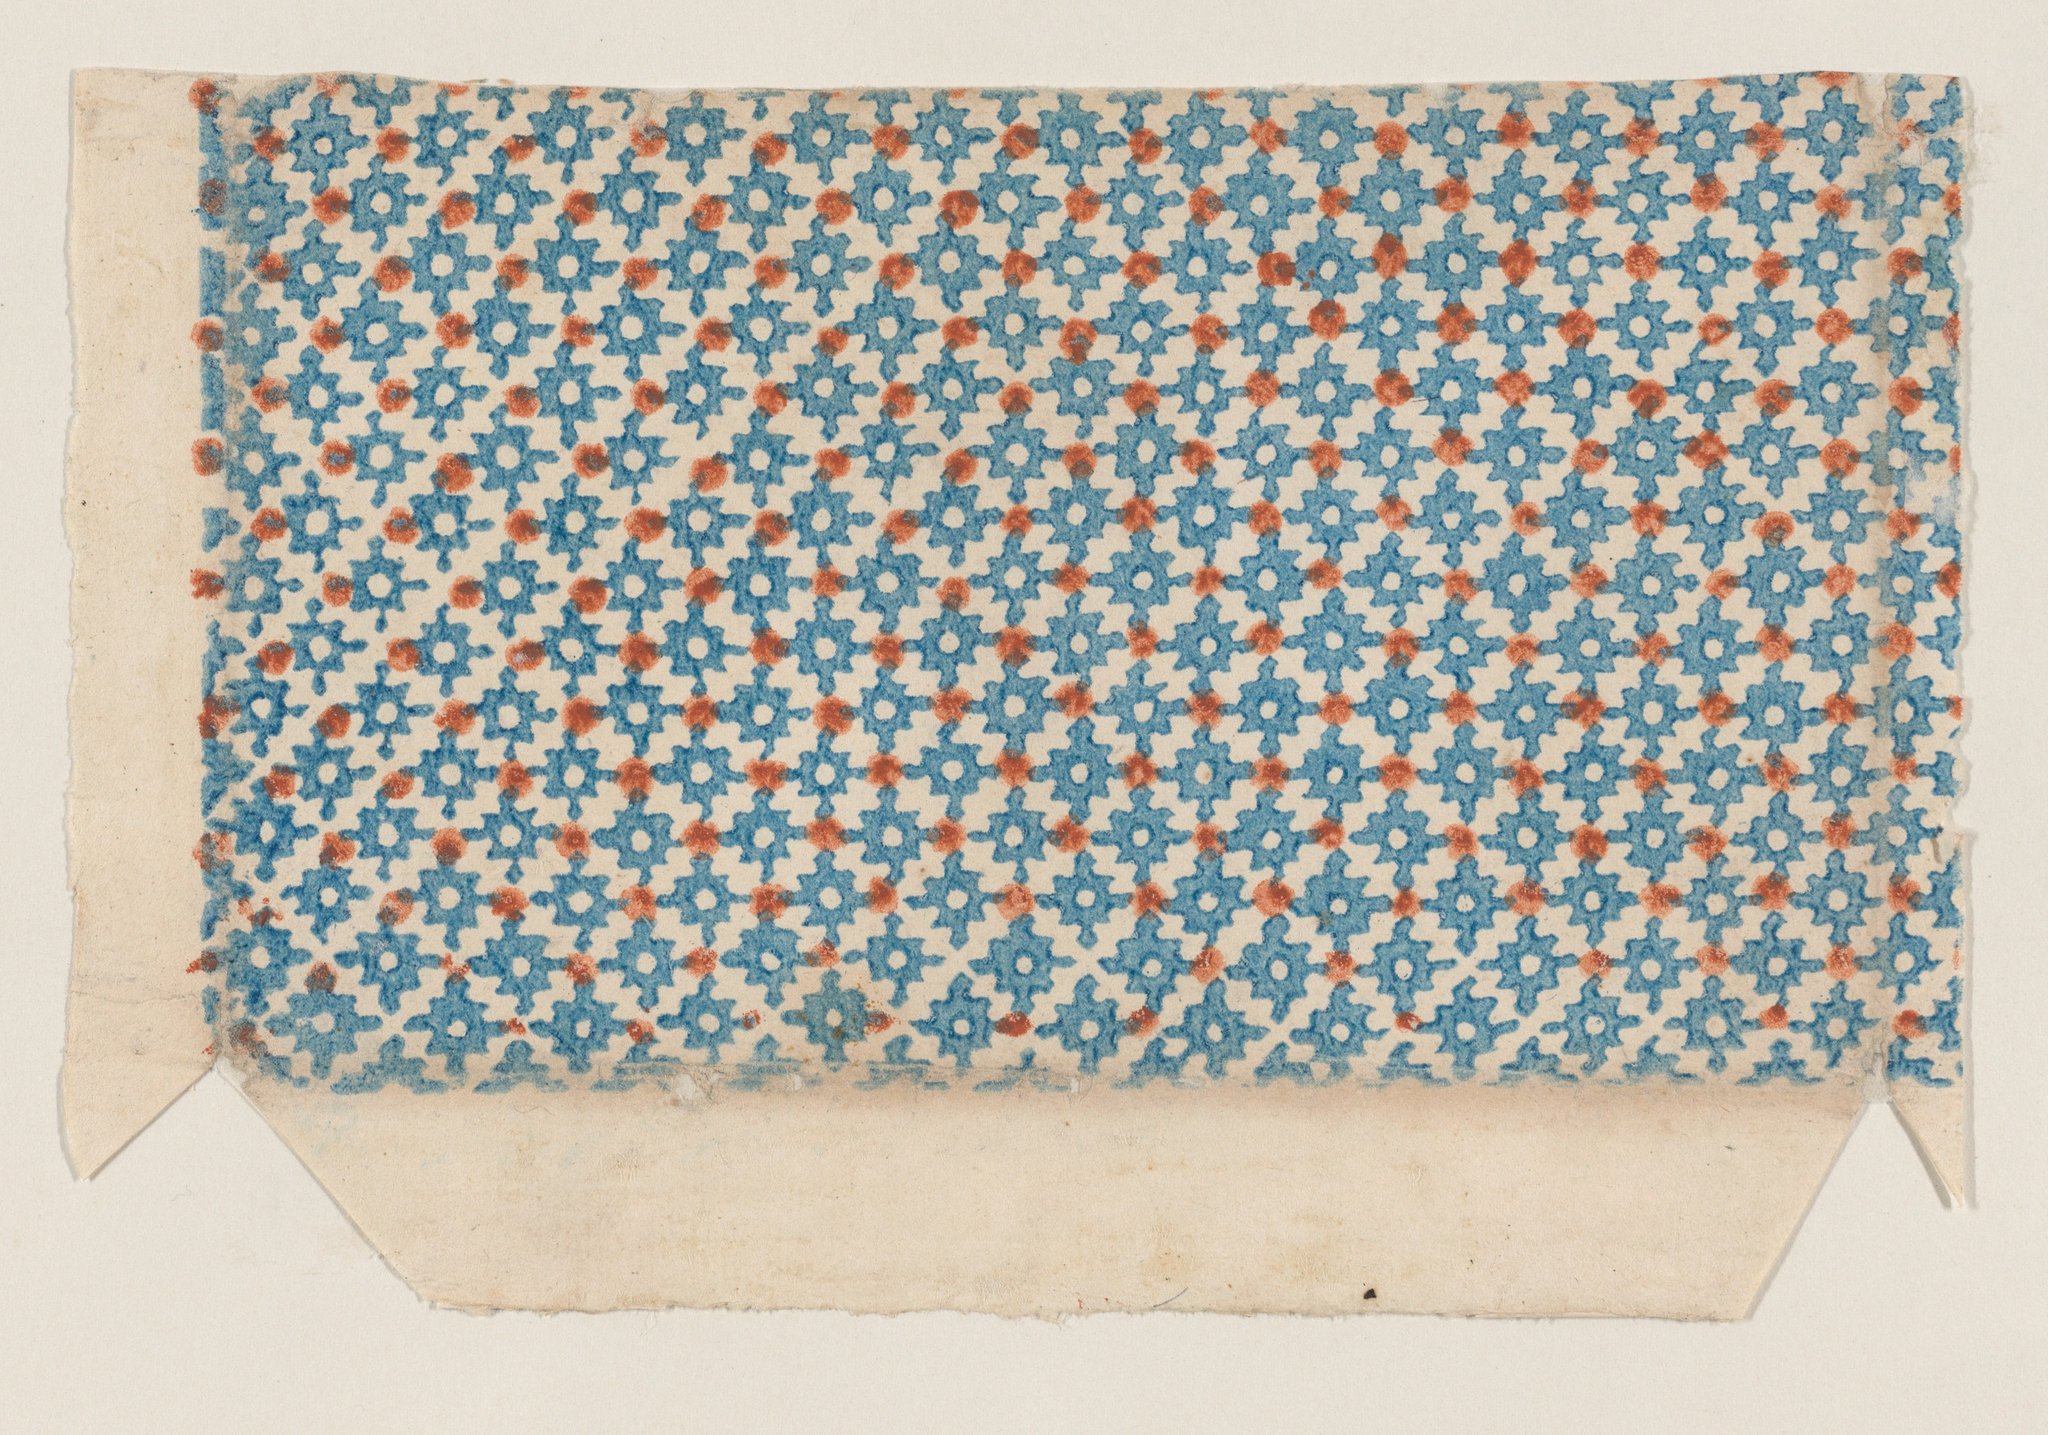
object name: print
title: Sheet with overall abstract pattern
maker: Anonymous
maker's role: artist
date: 1801-1900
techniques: relief print